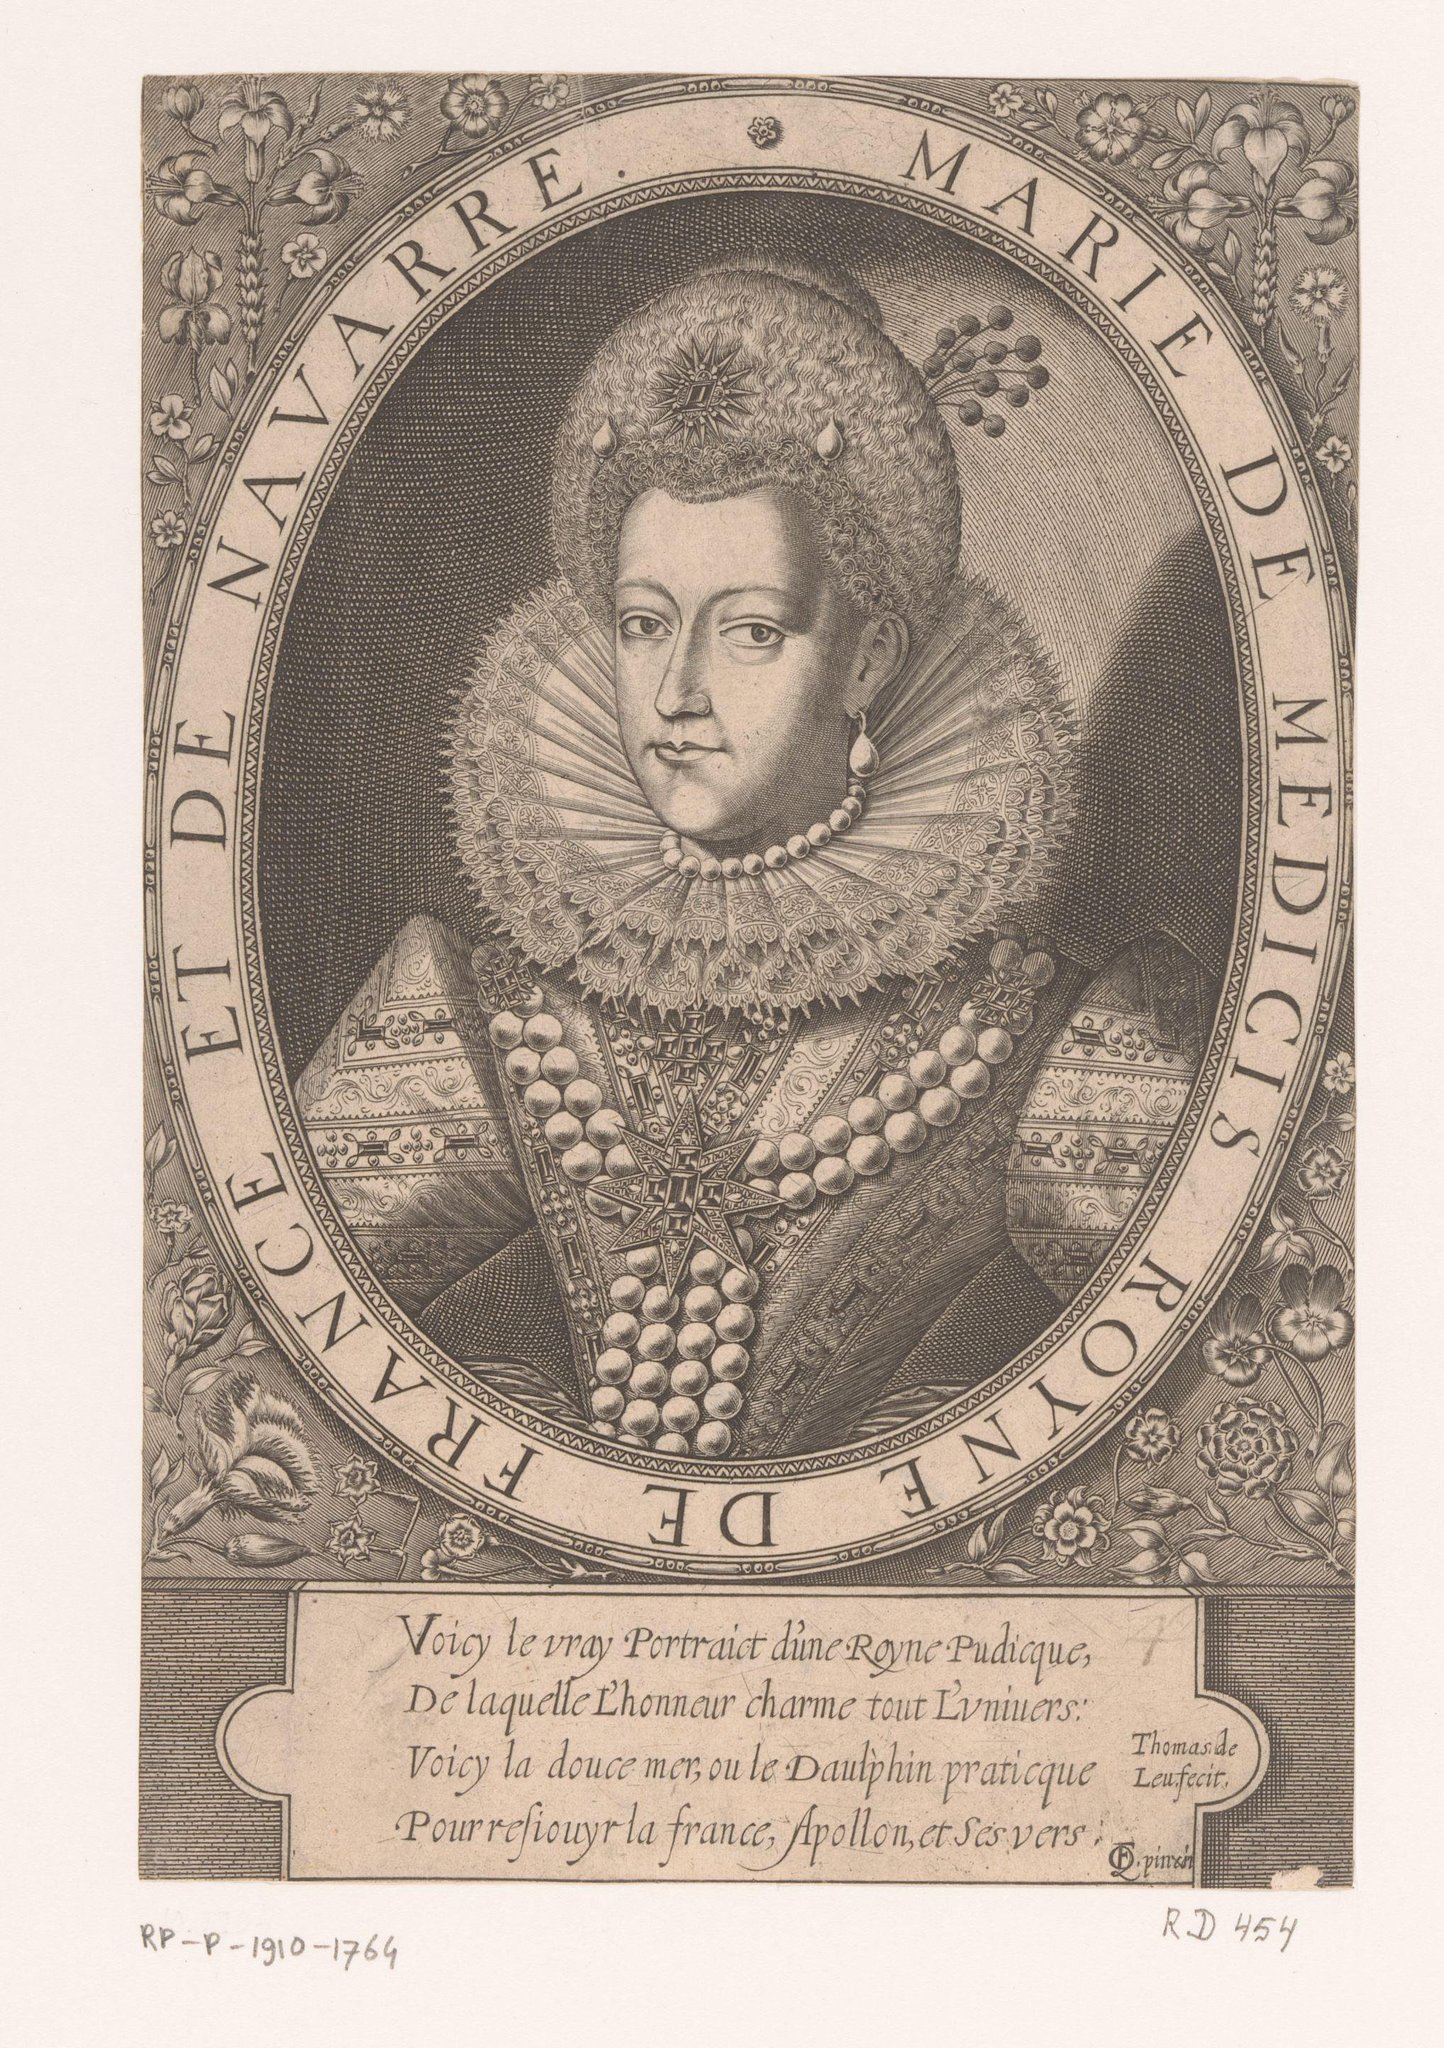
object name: print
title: Portret van Maria de' Medici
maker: thomas de leu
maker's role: print maker, publisher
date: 1576-1614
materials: paper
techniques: engraving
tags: cologne, print maker, maria de' medici, historical persons, queen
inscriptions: collector's mark: Lugt 2228